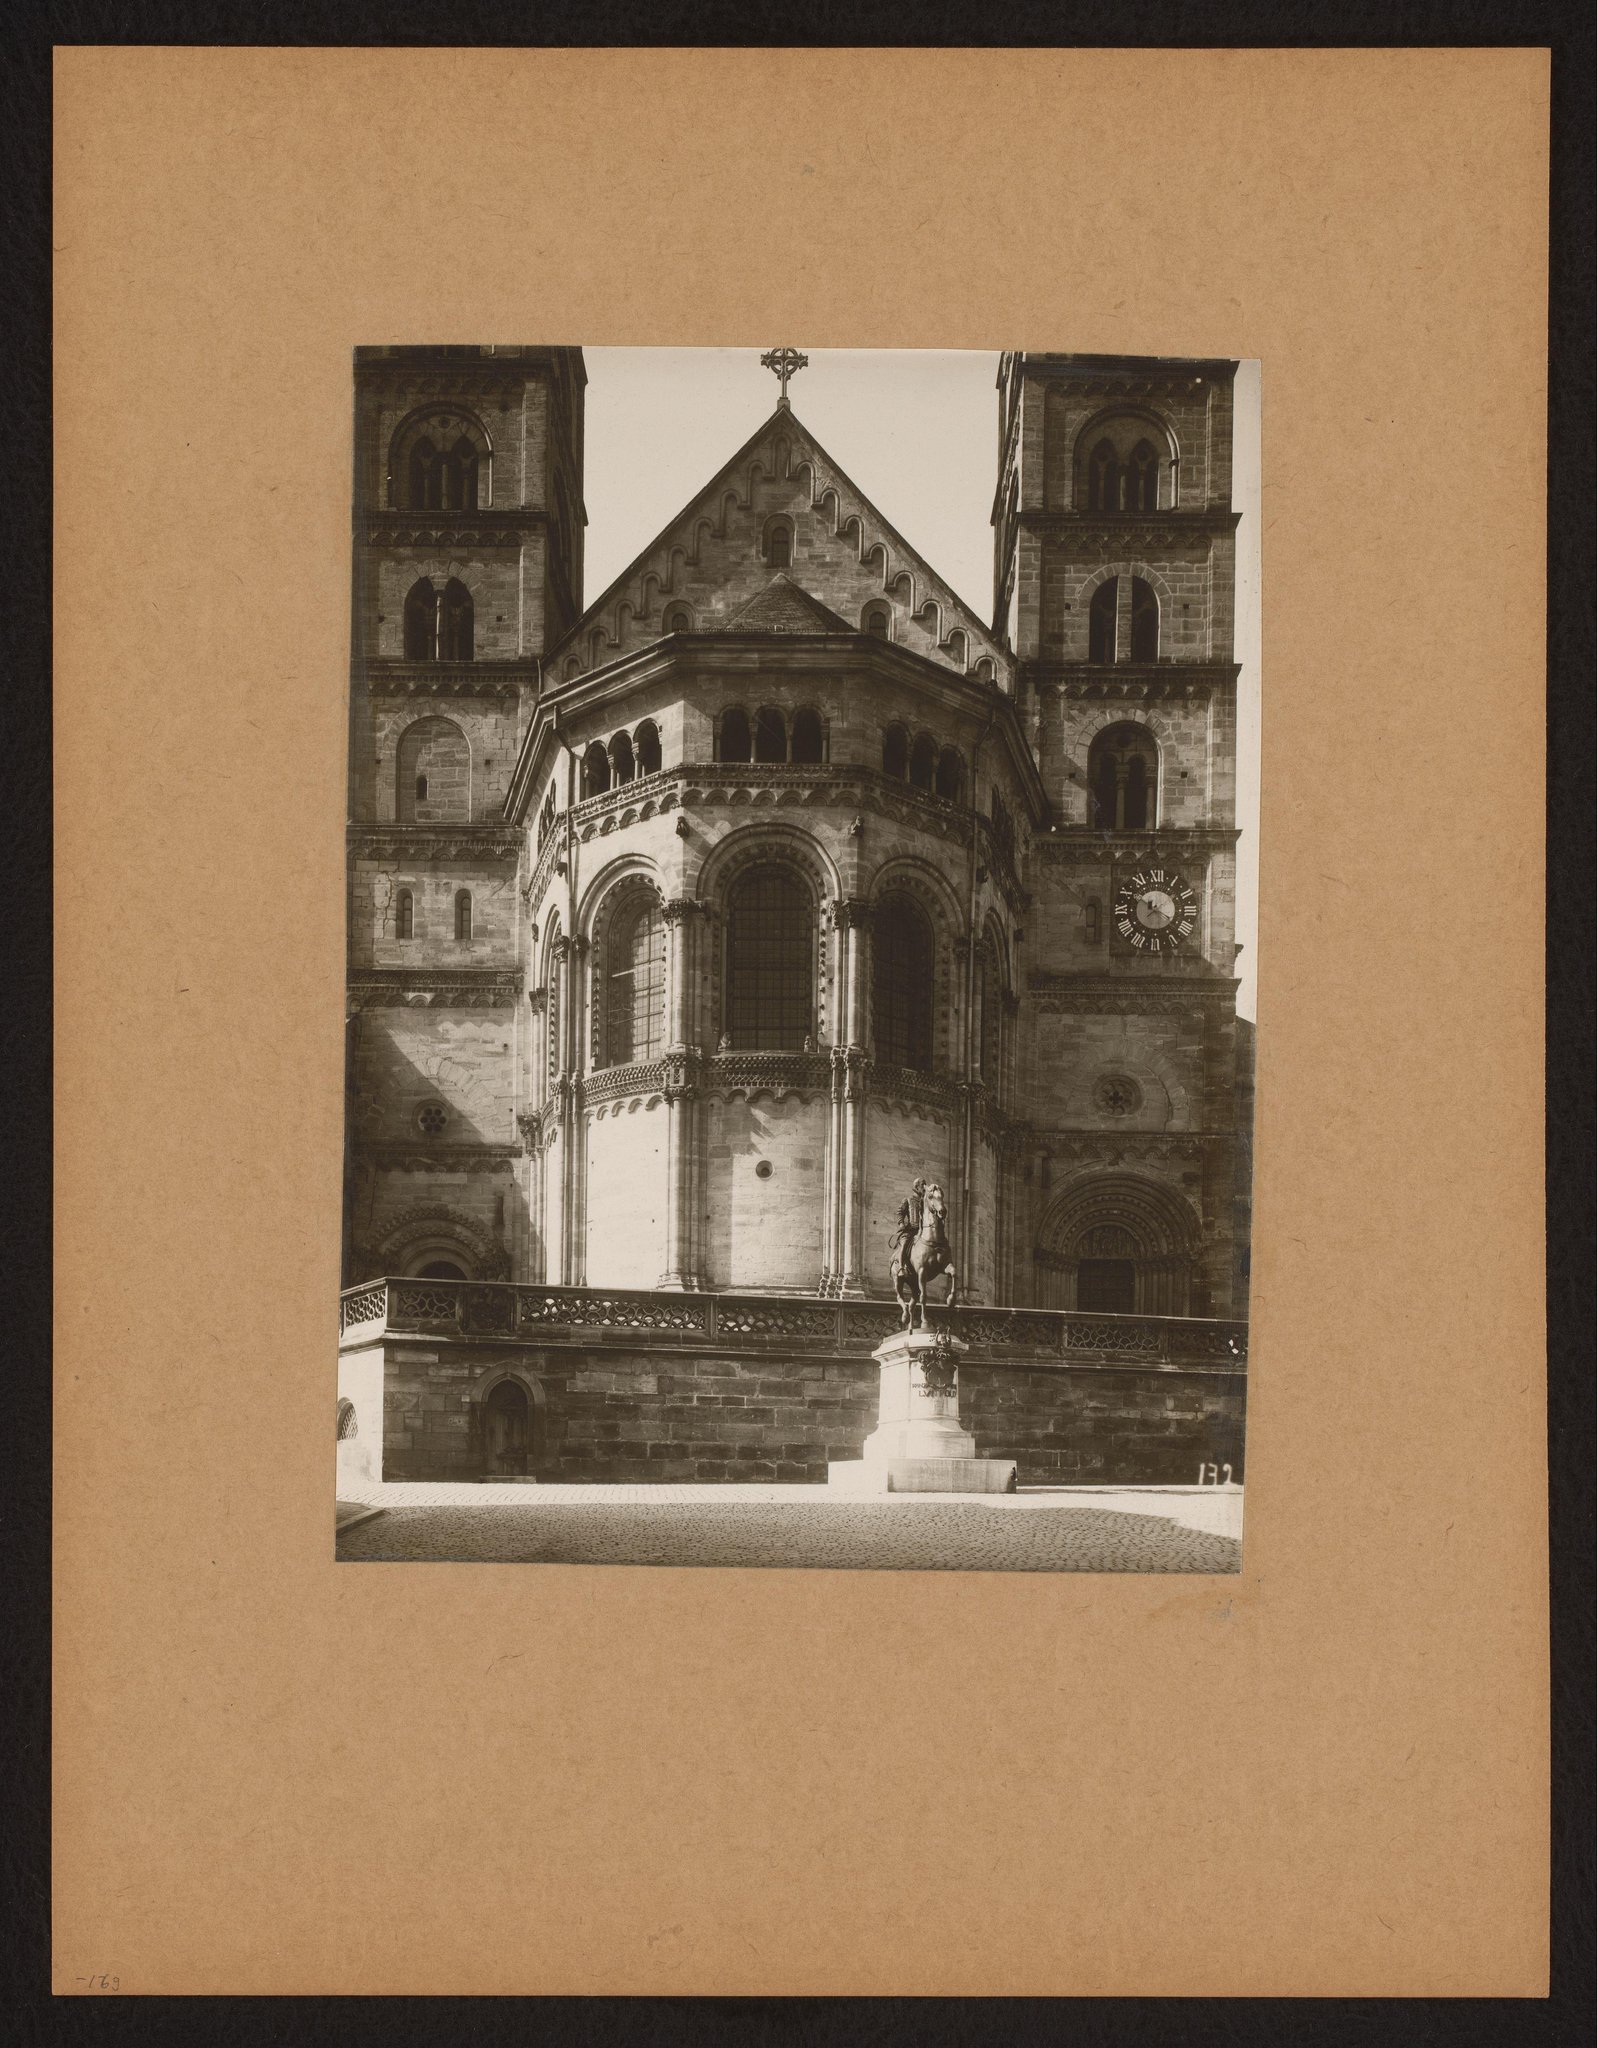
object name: album leaf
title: Gezicht op de dom van Bamberg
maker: Anonymous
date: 1900-1920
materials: paper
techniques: gelatin silver print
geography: bamberg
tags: church (exterior)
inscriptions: number: ‘172’